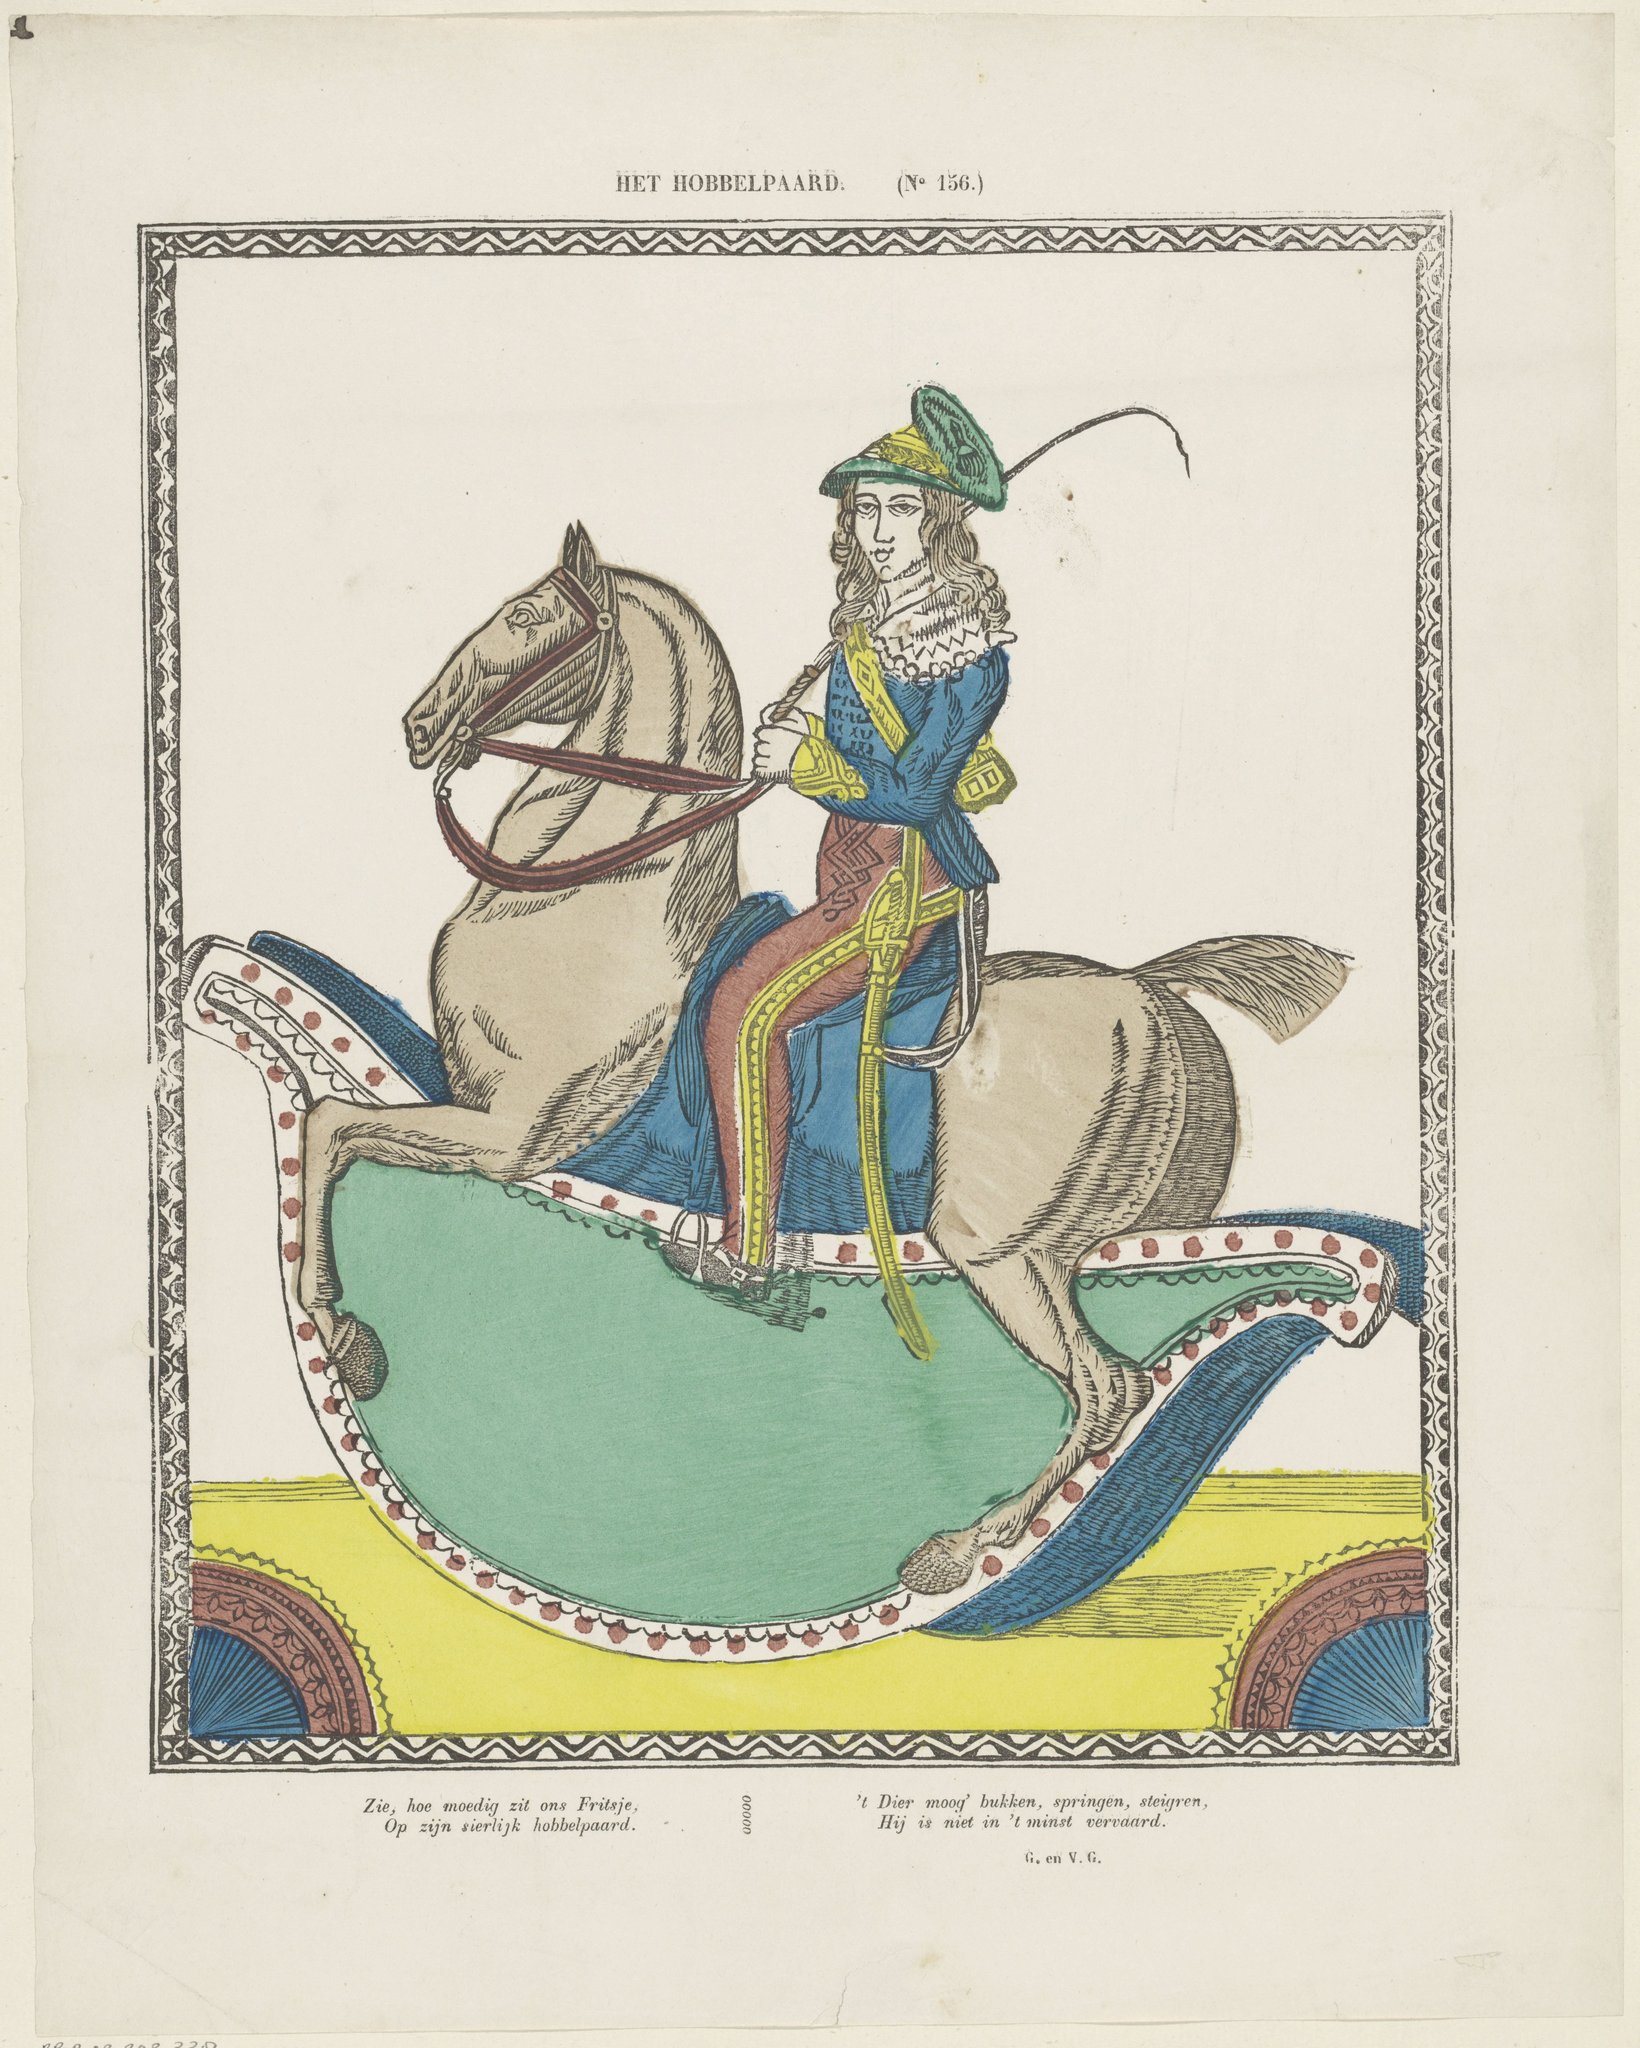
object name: popular print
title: Het hobbelpaard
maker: Anonymous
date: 1833-1856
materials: paper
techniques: colour, letterpress printing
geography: turnhout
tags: rocking-horse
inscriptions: collector's mark: Lugt 2760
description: Blad met een grote voorstelling van een jongen op een hobbelpaard. Geheel omgeven door een sierrand. In de ondermarge een vierregelig vers in twee kolommen. Genummerd midden boven: (No 156).